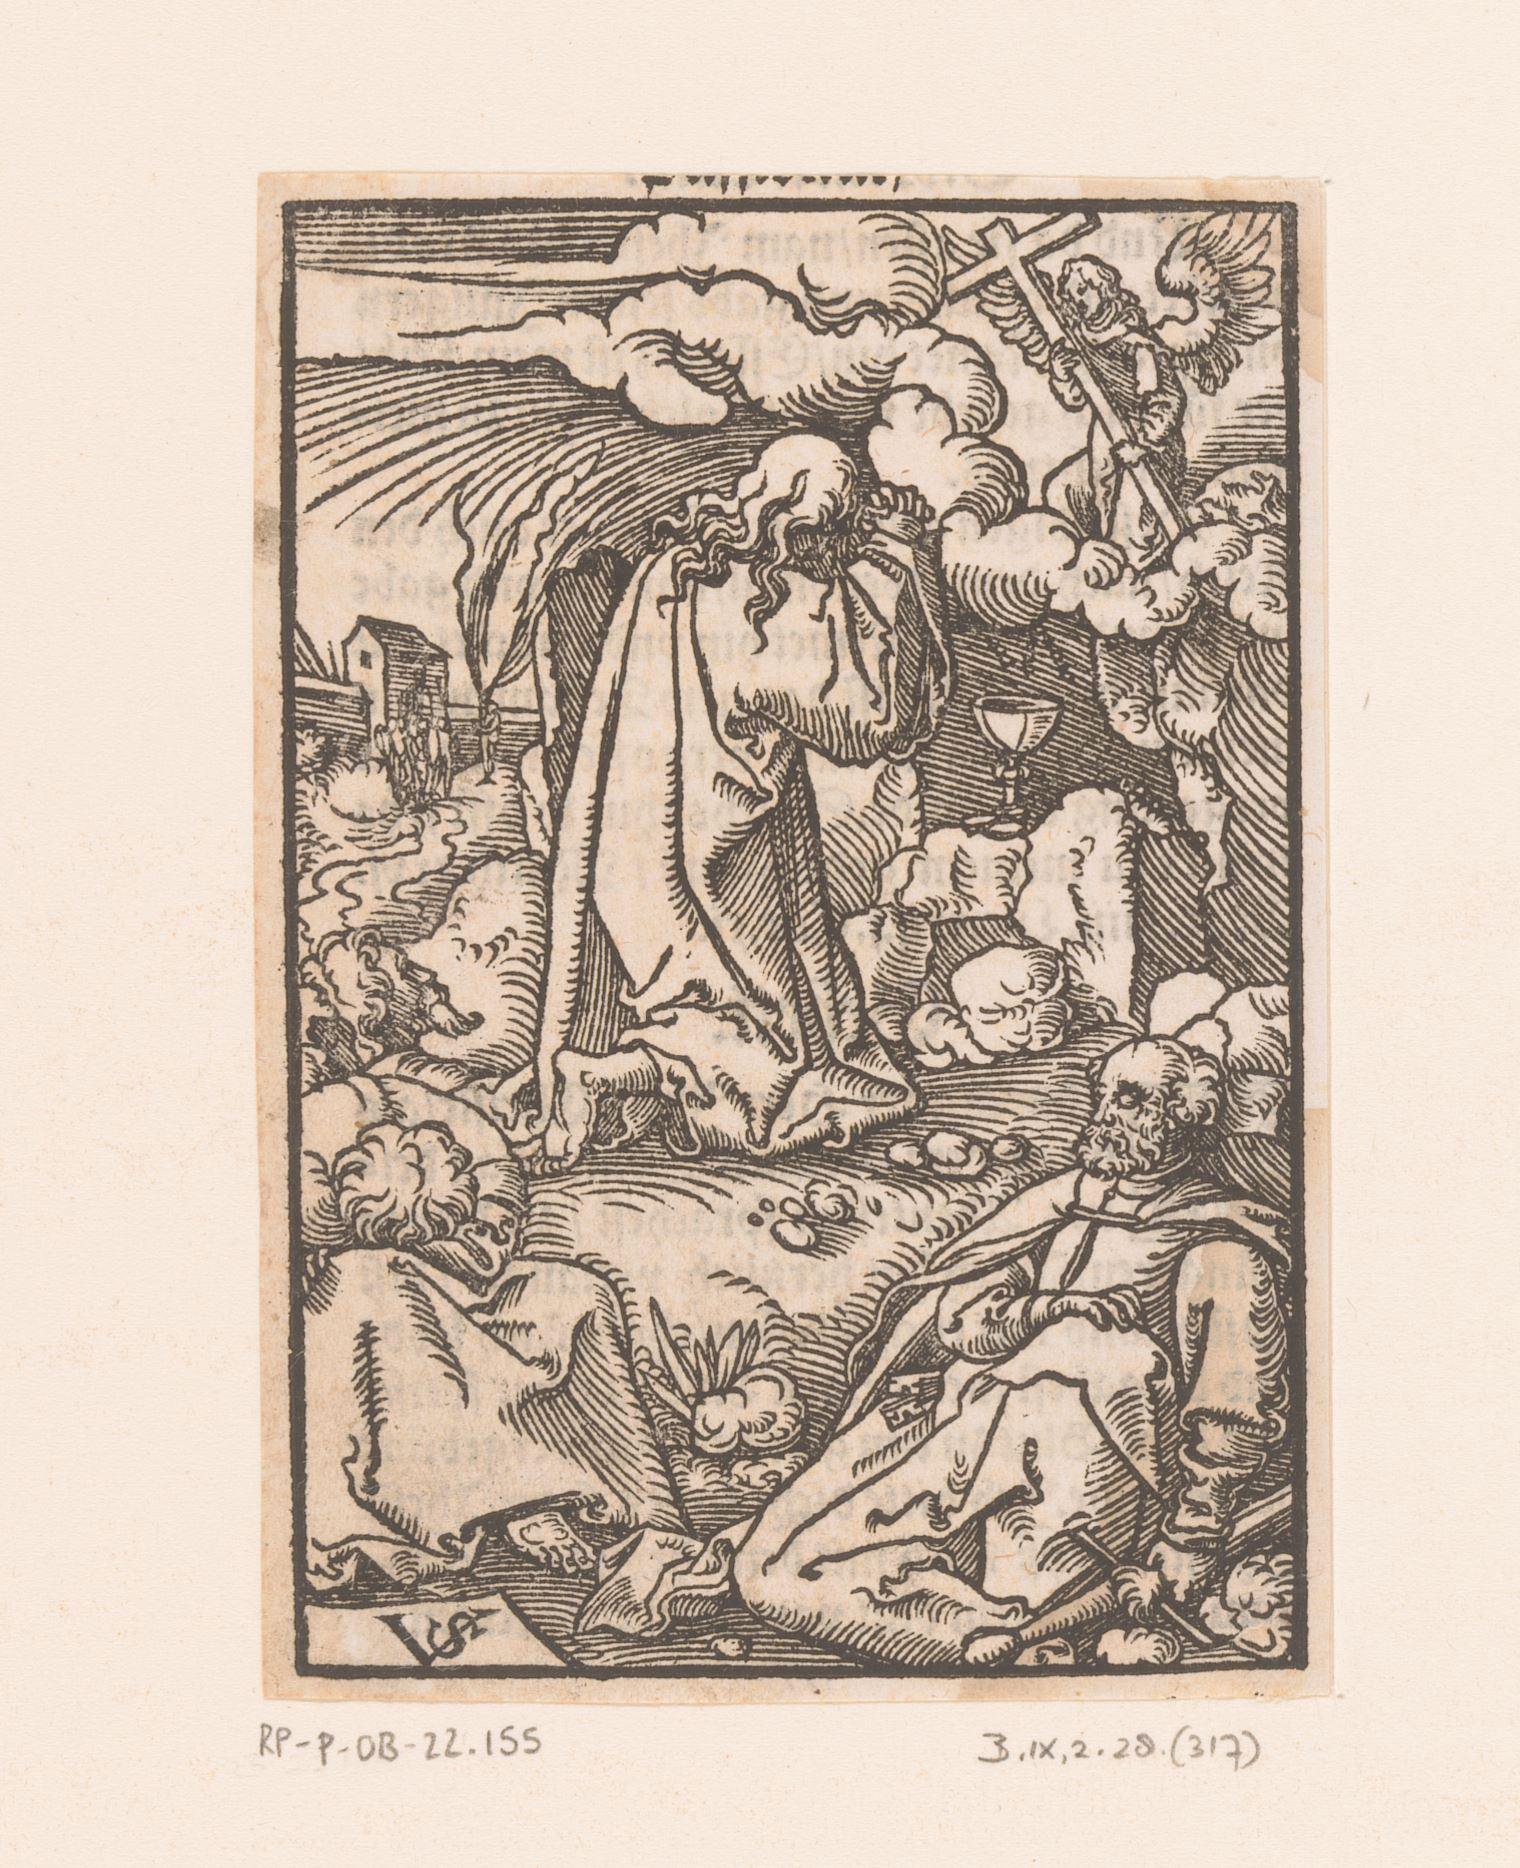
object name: book illustration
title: Christus in de hof van Getsemane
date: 1552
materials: paper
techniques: woodcut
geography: nuremberg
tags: agony of christ: to comfort him one or more angels appear to christ with chalice and/or cross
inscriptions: number: ‘181’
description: Gebruikt voor verschillende publicaties die werden gedrukt door Valentin Geißler tussen 1552 en 1560 te Neurenberg.